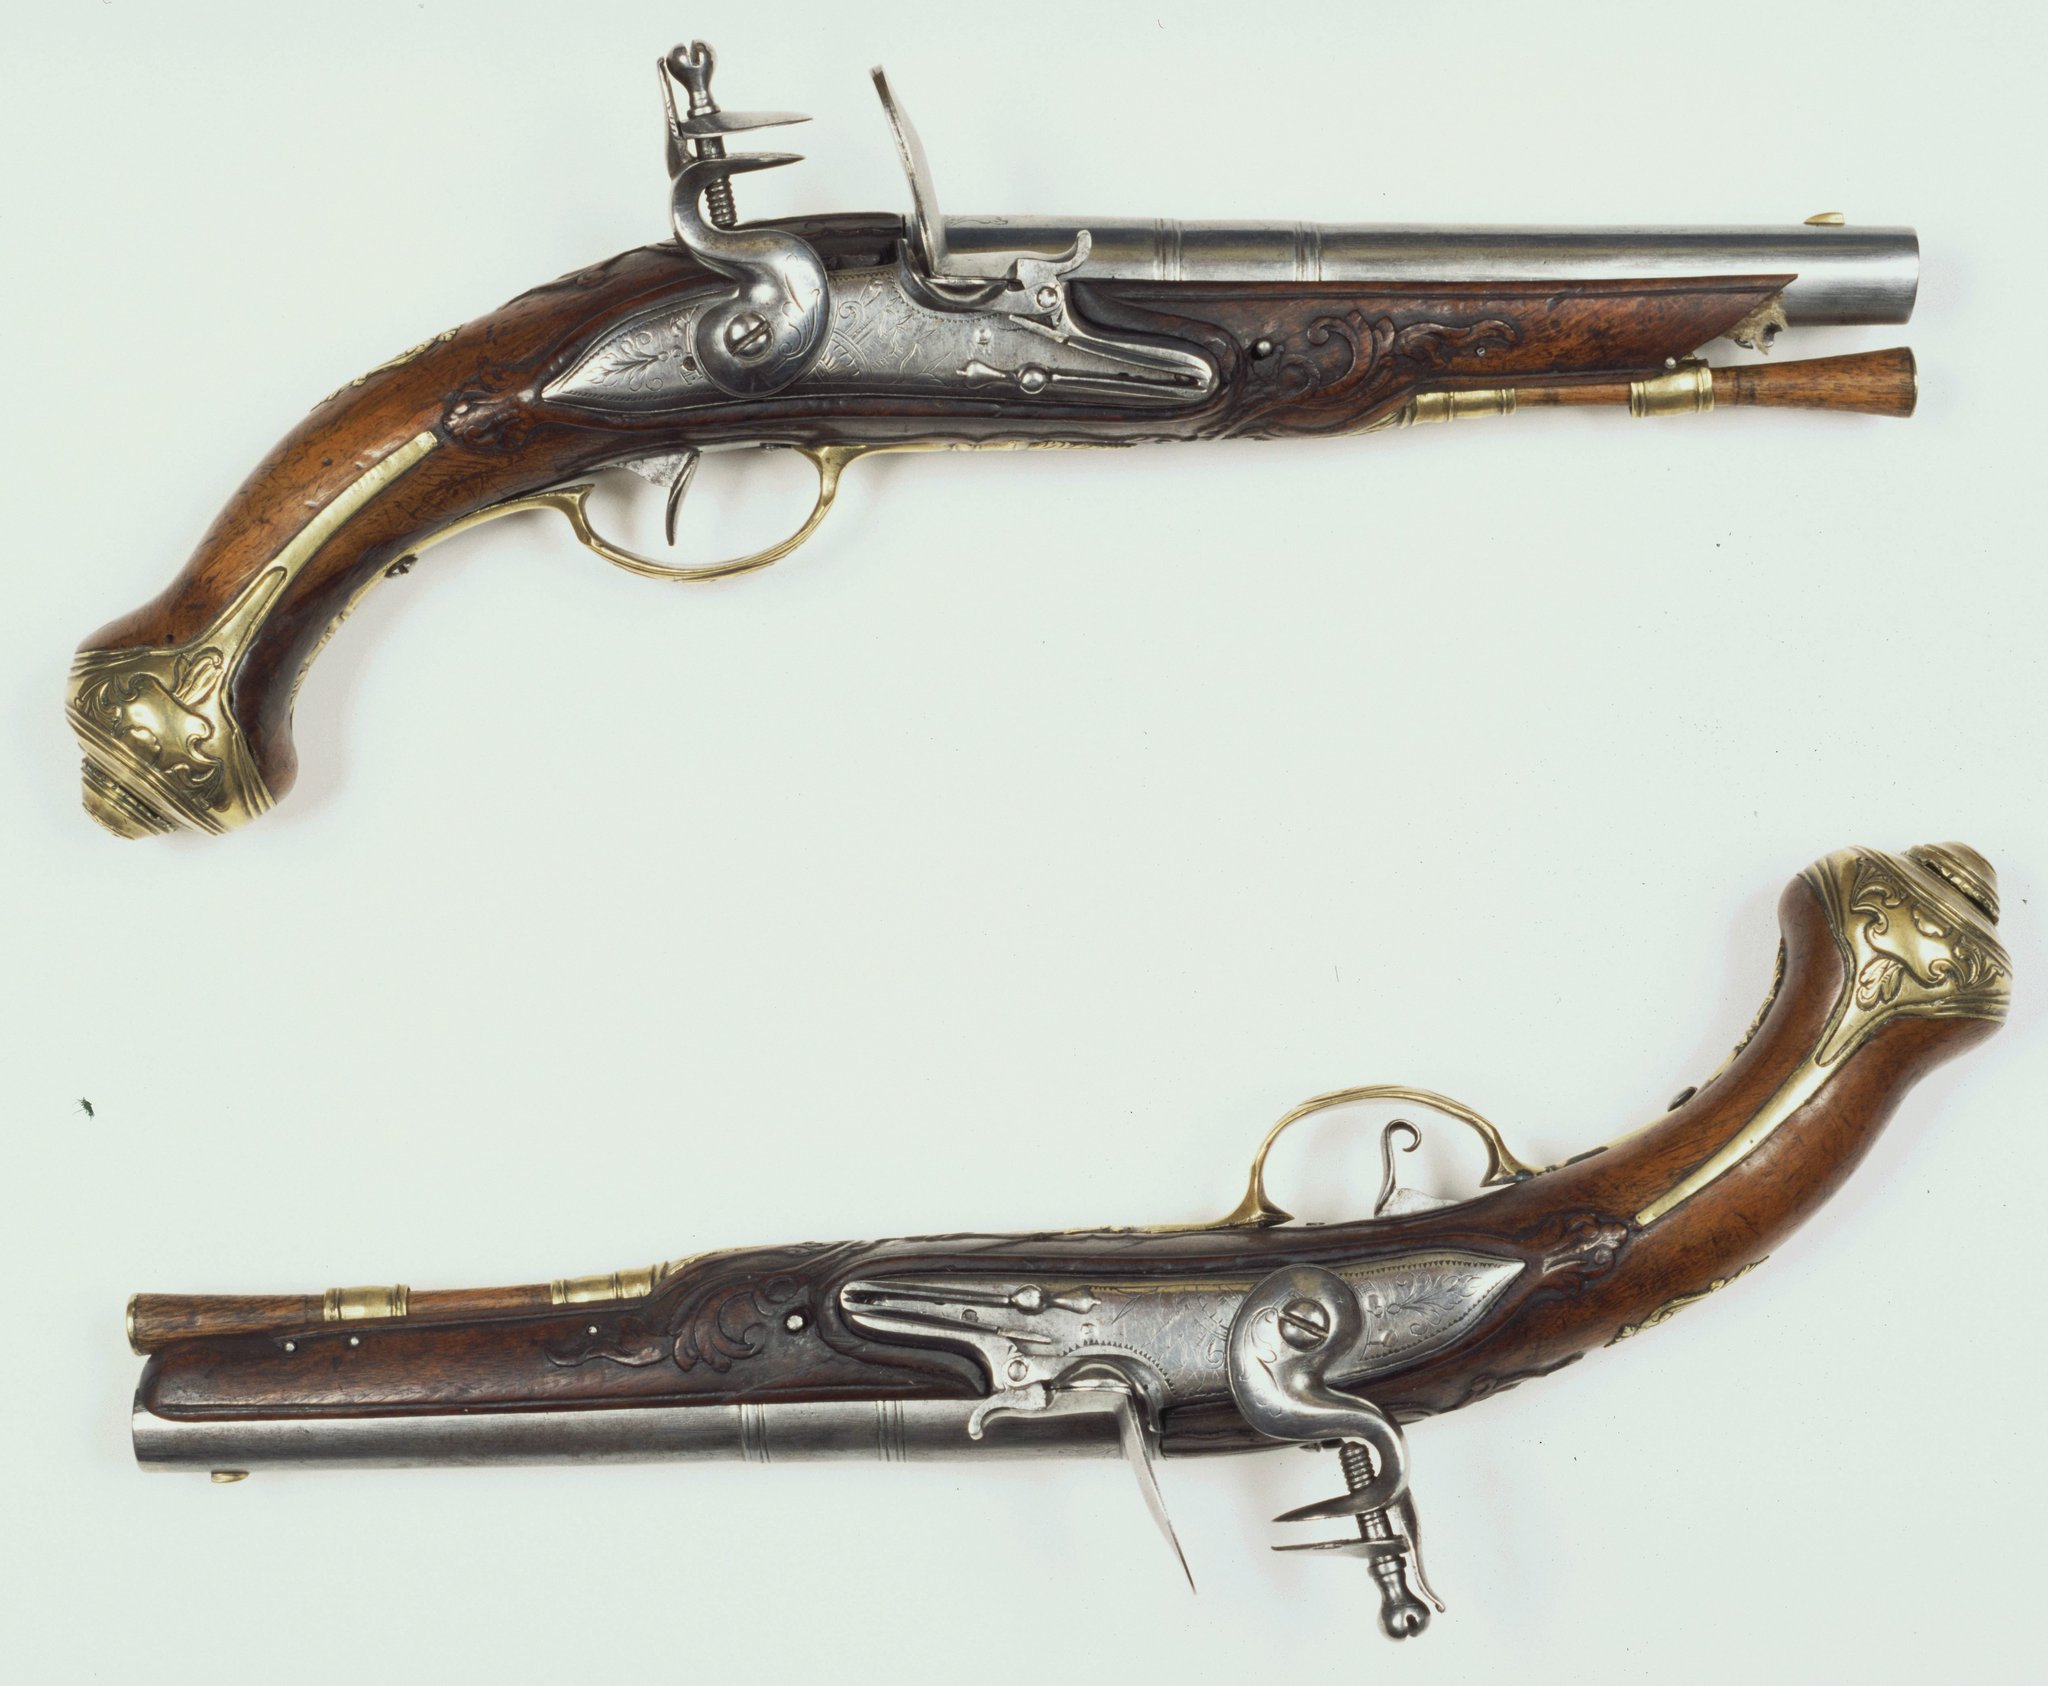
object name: flintlock pistol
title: Vuursteenpistool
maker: Anonymous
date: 1880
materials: brass, bronze, iron, wood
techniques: engraving, relief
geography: london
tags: netherlands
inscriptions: mark: ‘London’, mark: ‘E.L.G.’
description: Vuursteenpistool, deel van koppel, met ronde gladde loop, onderbroken door drie profielbanden met aan het einde van de loop een messing vizierkorrel en aan het begin de naam 'LONDON' gegraveerd. Houten lade met ingekerfde bladmotieven. IJzeren ronde slotplaat met gegraveerde voorstellingen van vaandels en bladeren, links op de slotplaat de letters 'E.L.G.' in staan gegraveerd. Houten kolf met ingekerfde bladmotieven en een kolfplaat van messing waar bladeren in staan gegraveerd. Messing beslag op de linkerkant van de lade. Trekkerbeugel is van messing waarvan de uiteinden de vorm van een blad hebben. IJzeren trekker. De laadstok is van hout met een kop van messing.